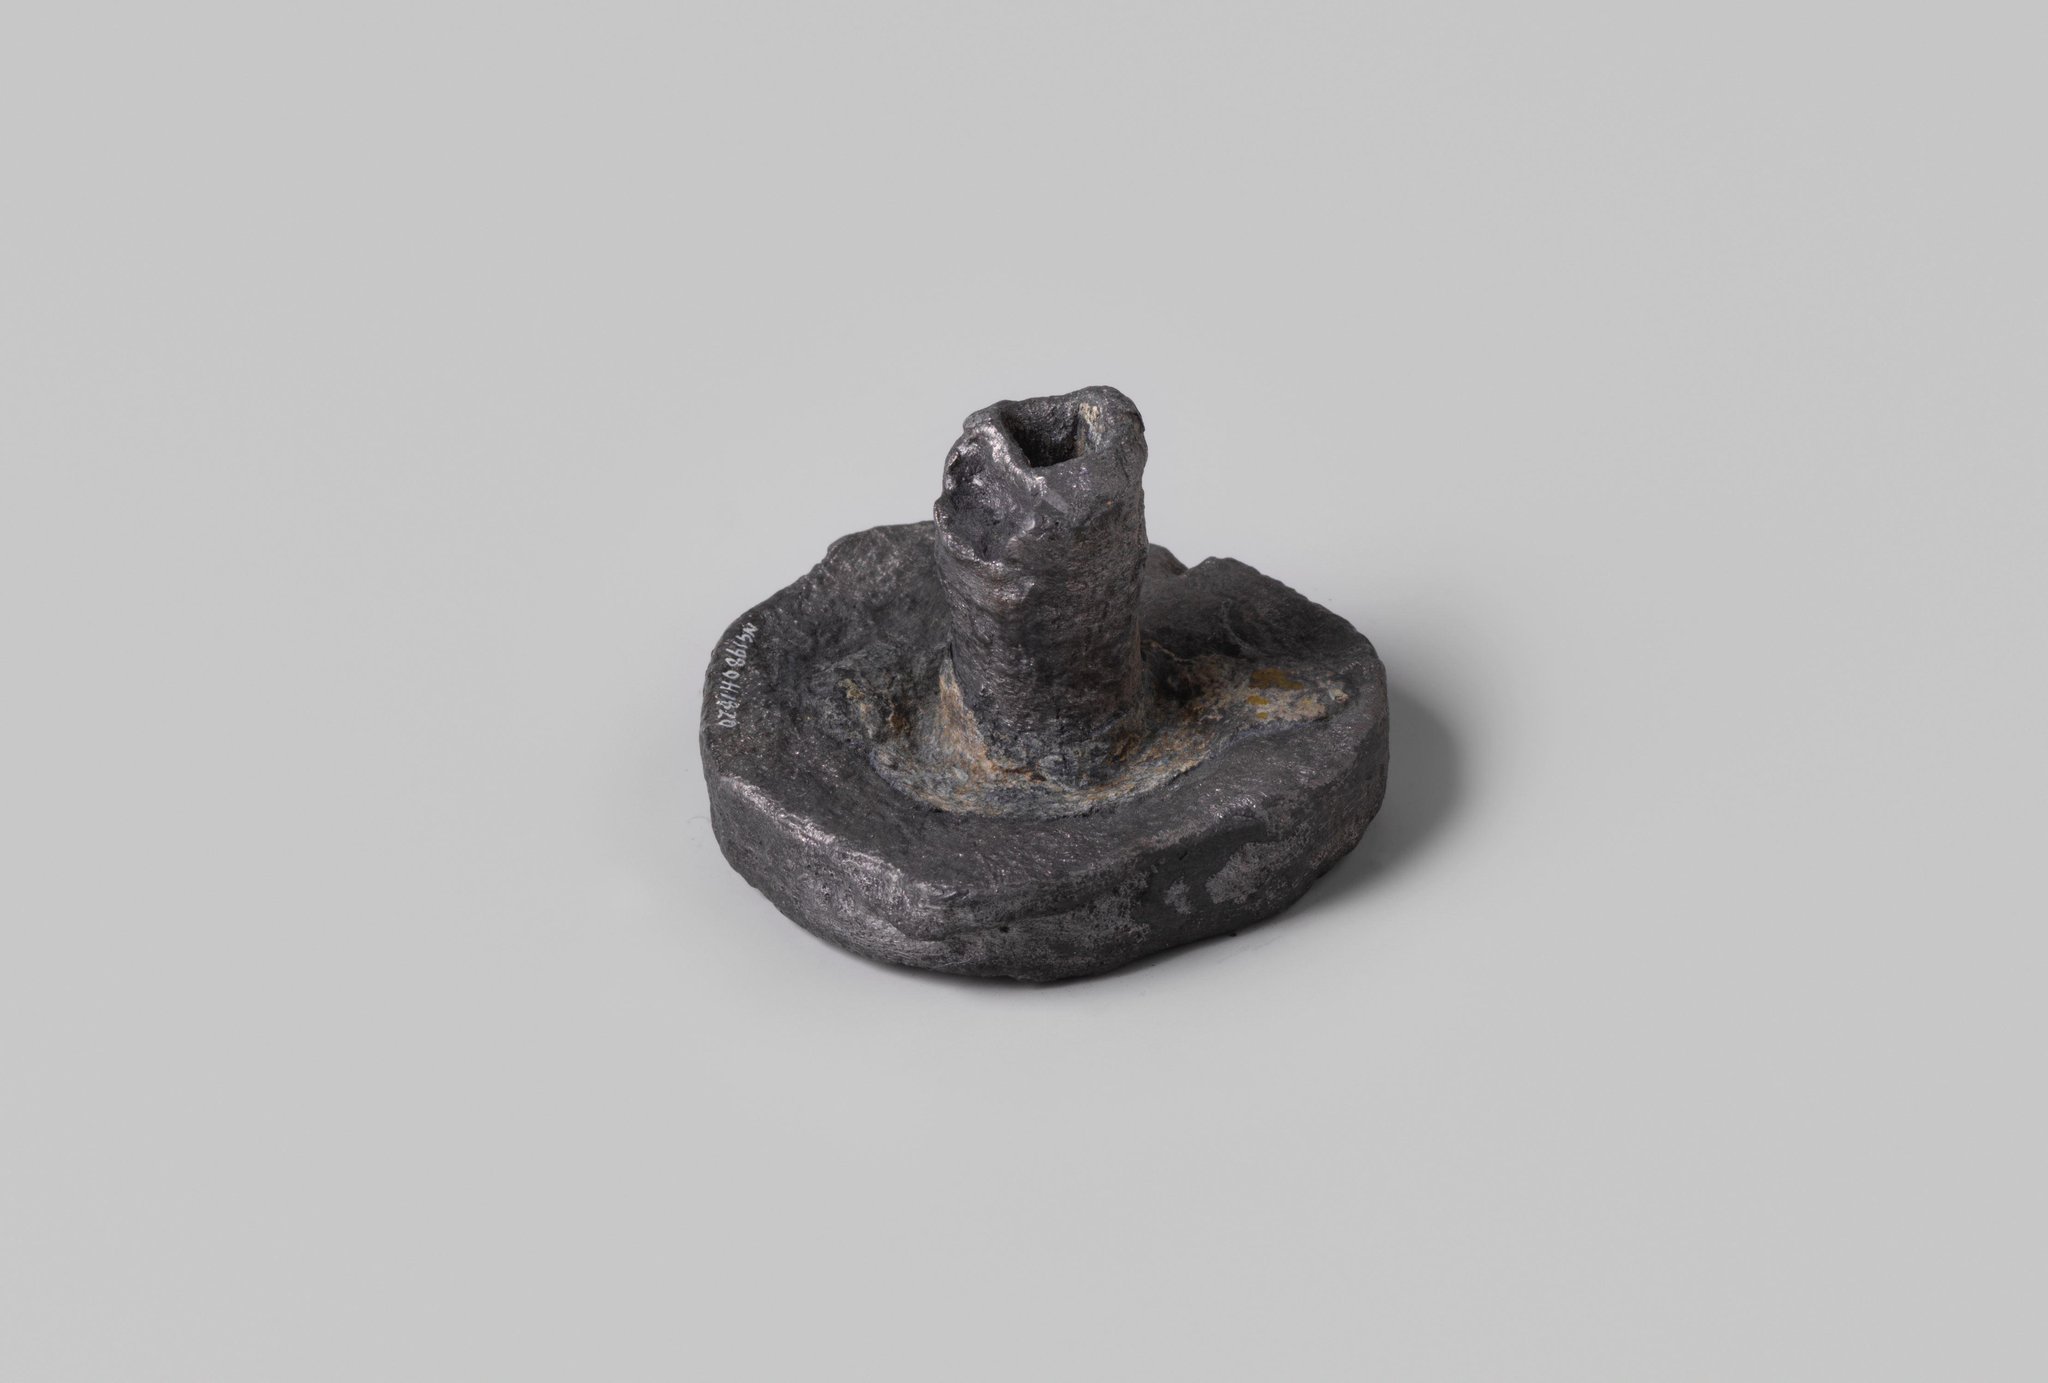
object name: weight scale component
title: Lead weight from the wreck of the Dutch East India ship Hollandia, dated 1743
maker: Anonymous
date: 1700-1743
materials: lead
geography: netherlands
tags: verenigde oostindische compagnie, hollandia (schip), annet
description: Ring-handle weight, top, oval disc, concave underneath with round shaft in centre, hollow core square, flat top with 2 holes for handle, 3 inscriptions (VIII), coat of arms on either side eroded (cf.NG1980-27H3325b).